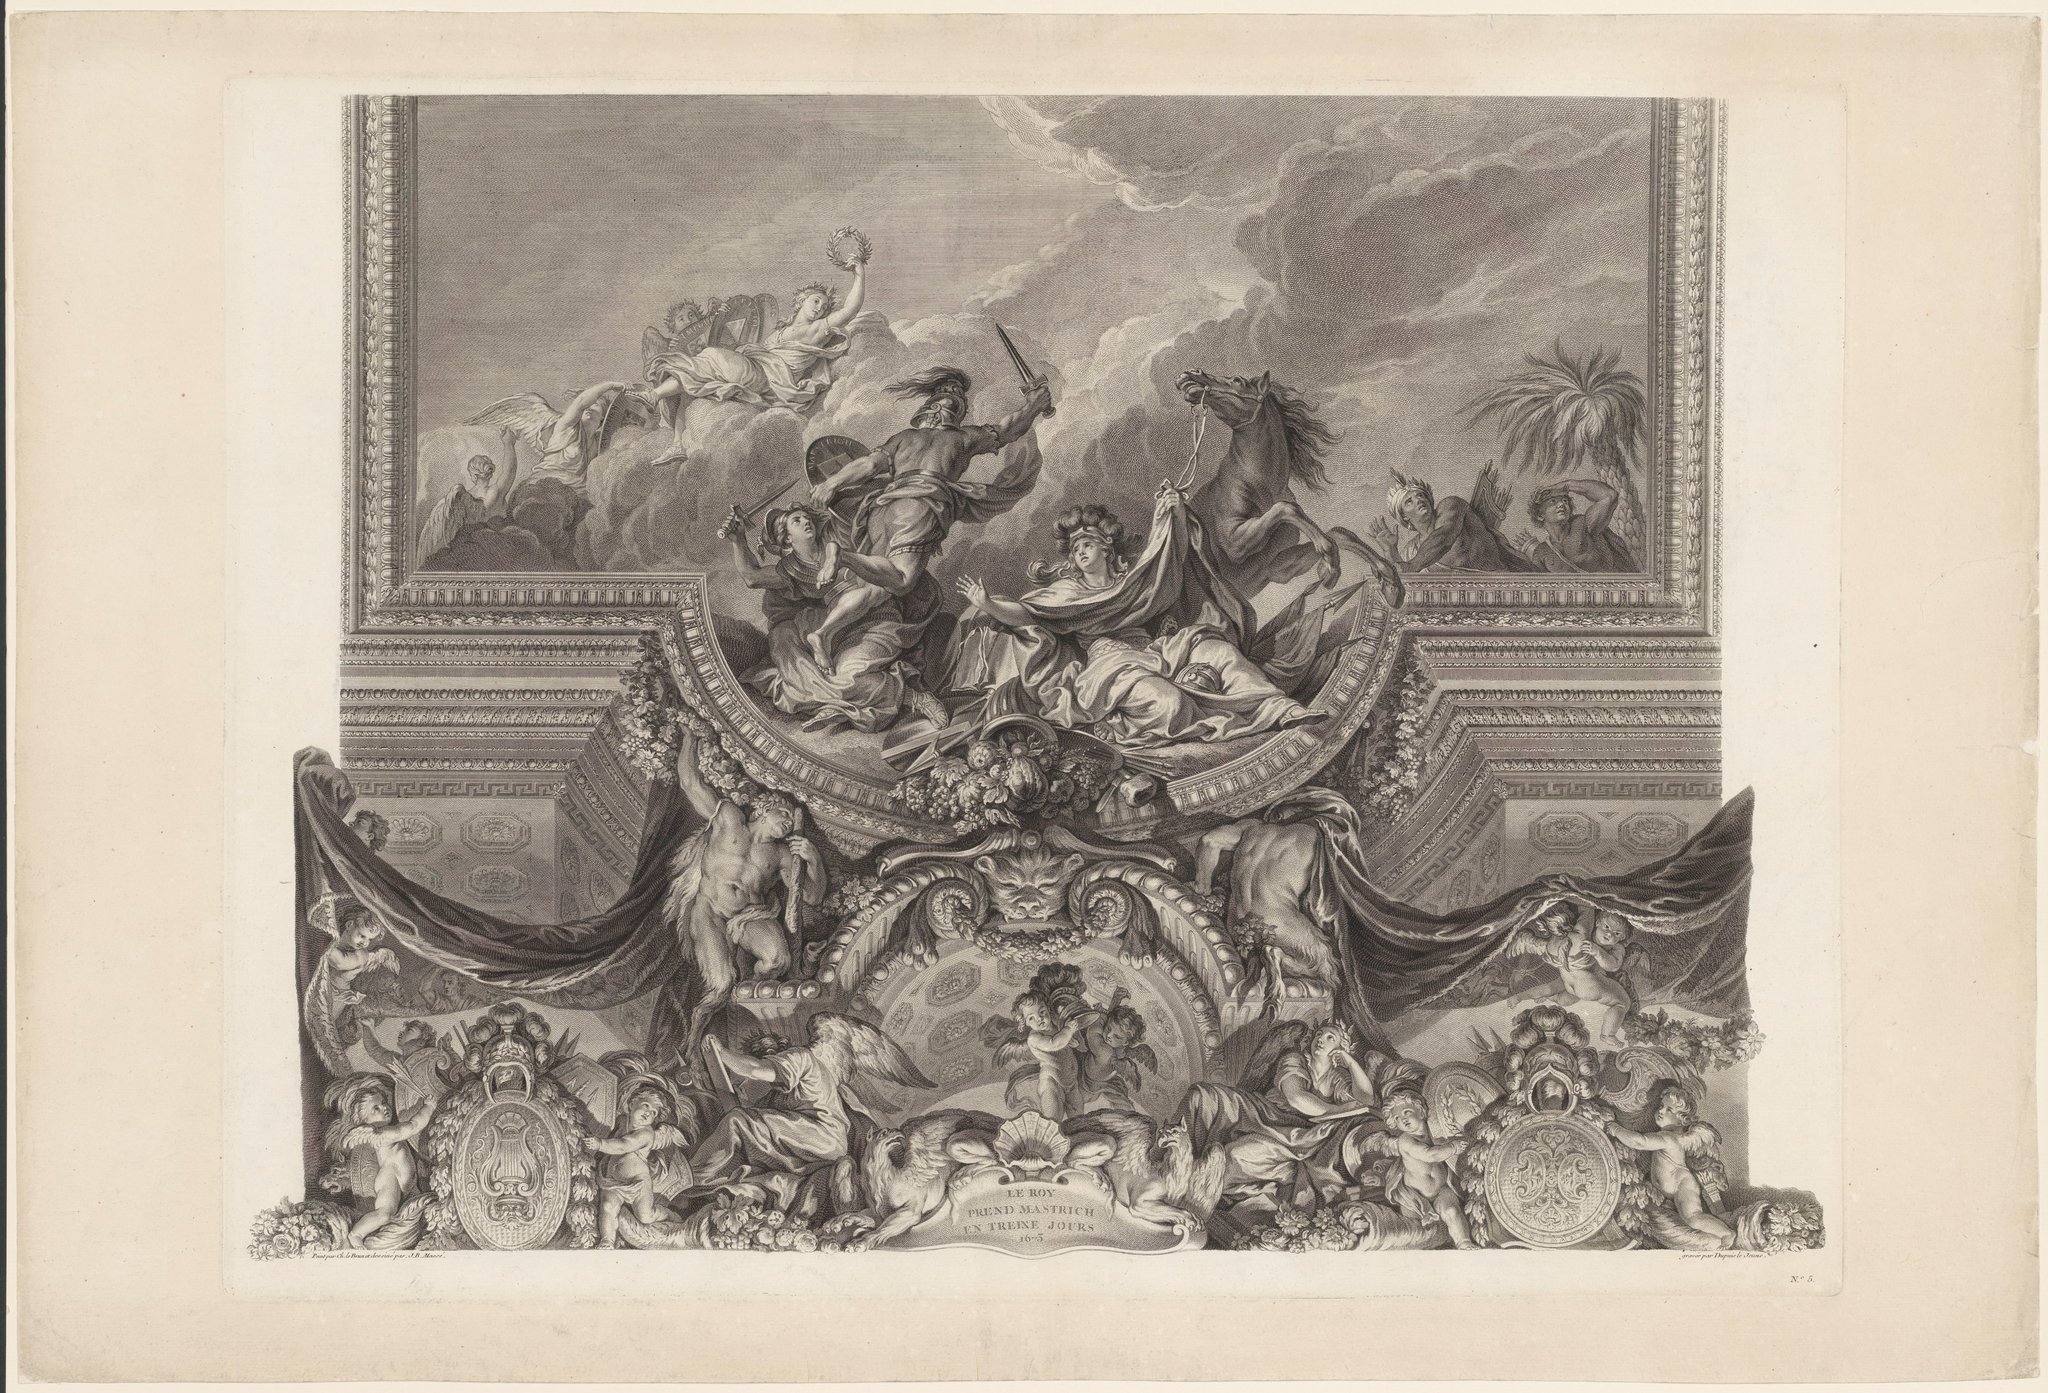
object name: print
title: Plafondschildering in de Spiegelzaal van Kasteel Versailles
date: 1752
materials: paper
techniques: engraving, etching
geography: paris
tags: ornaments ~ art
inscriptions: collector's mark: Lugt 2228, number: ‘No. 5.’